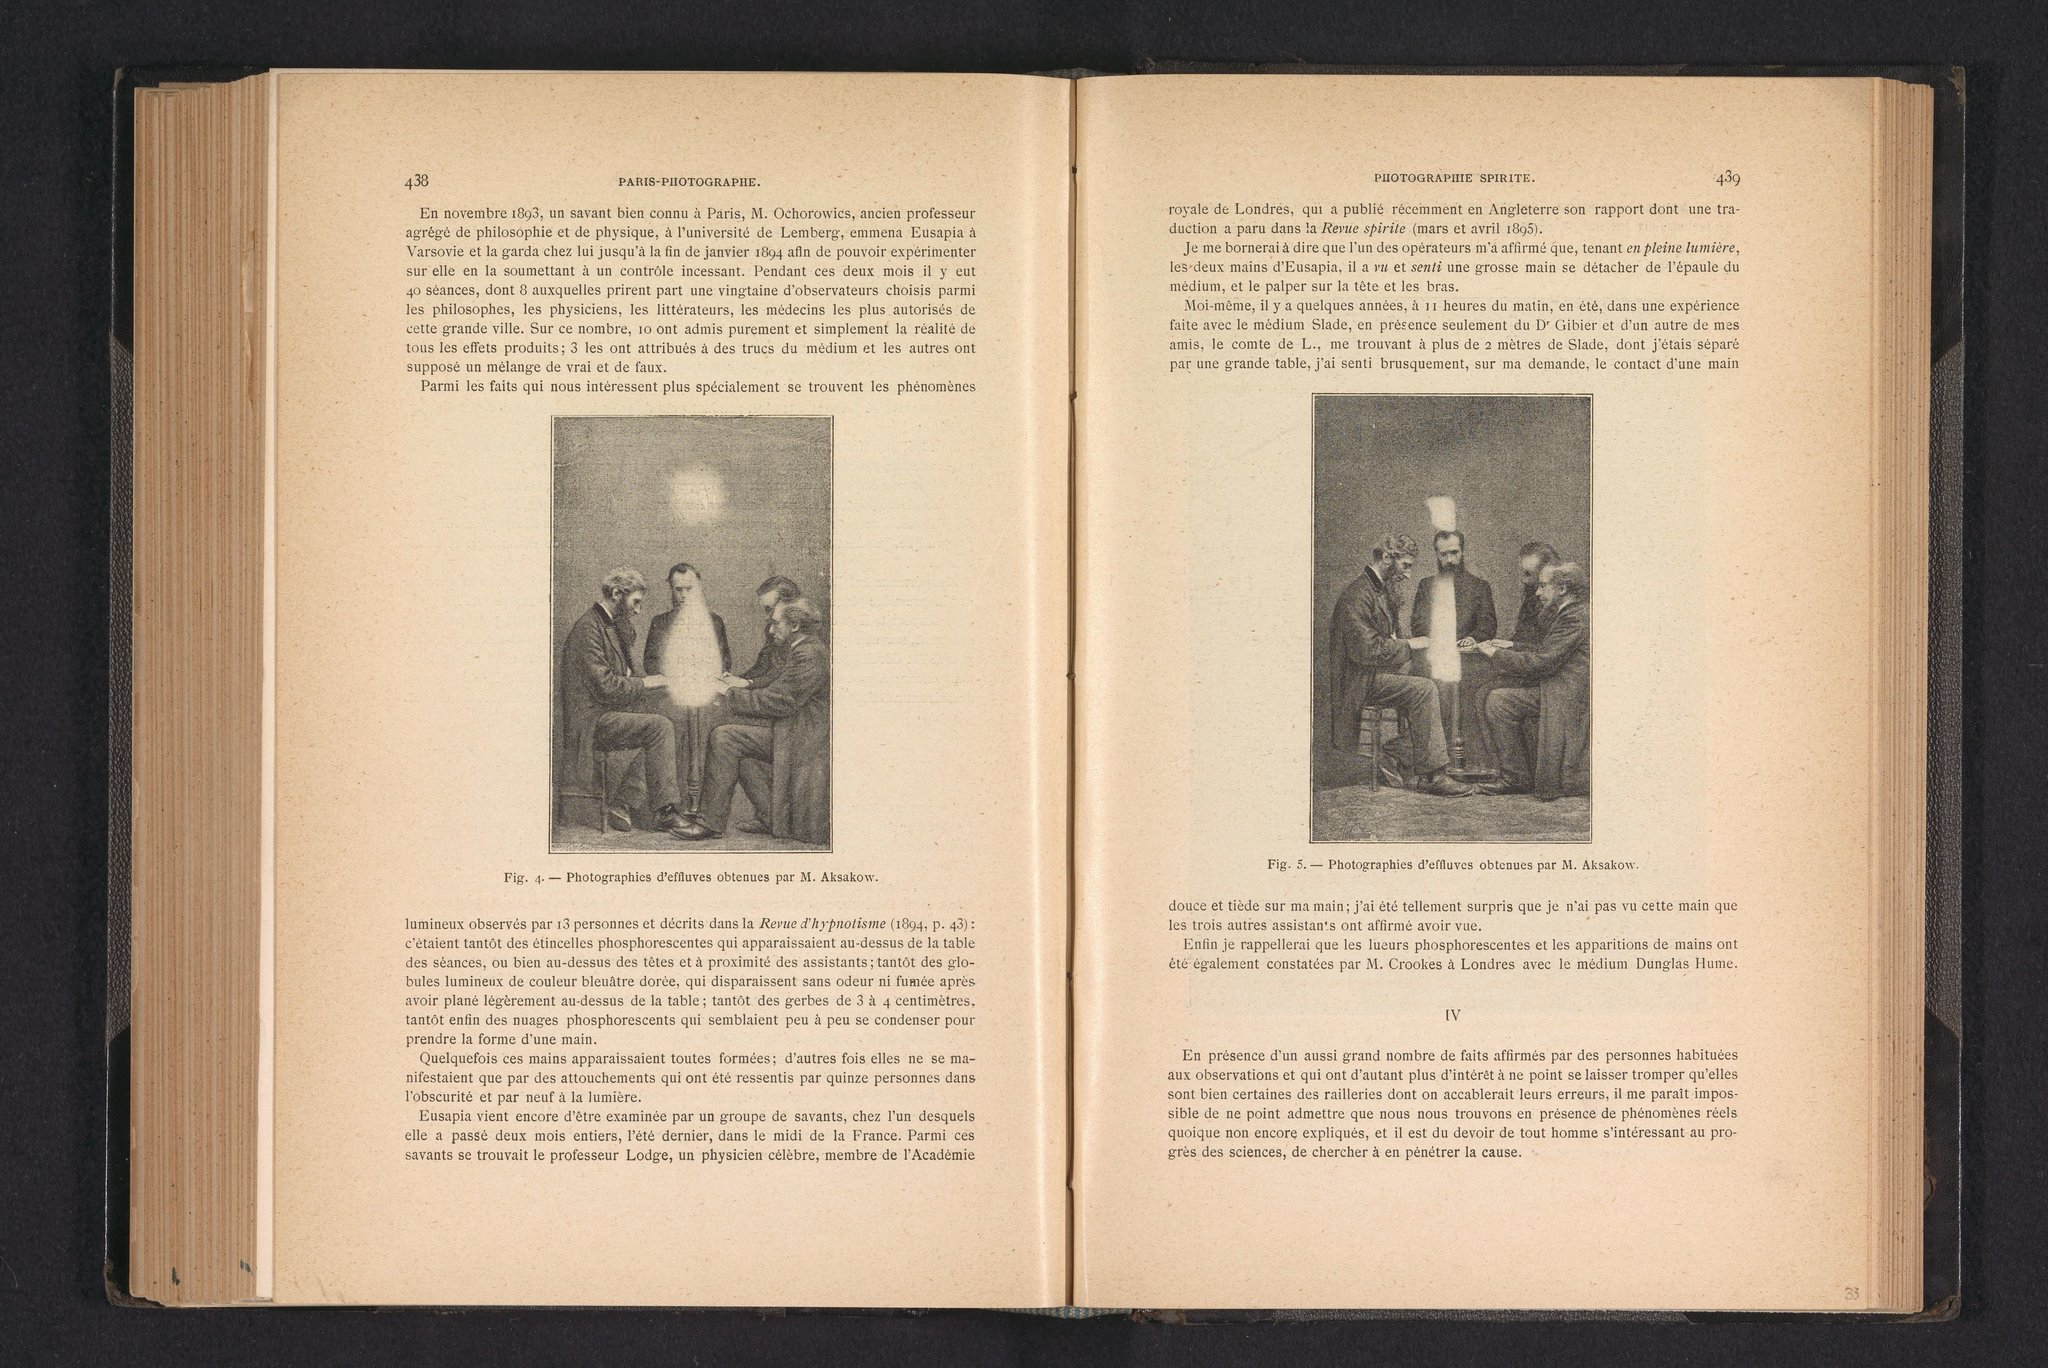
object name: photomechanical print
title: Vier mannen rond een tafel met een emanatie zichtbaar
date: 1884-1894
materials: paper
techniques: autotype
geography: france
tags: telekinesis, teleportation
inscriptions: number: ‘Fig. 4.’